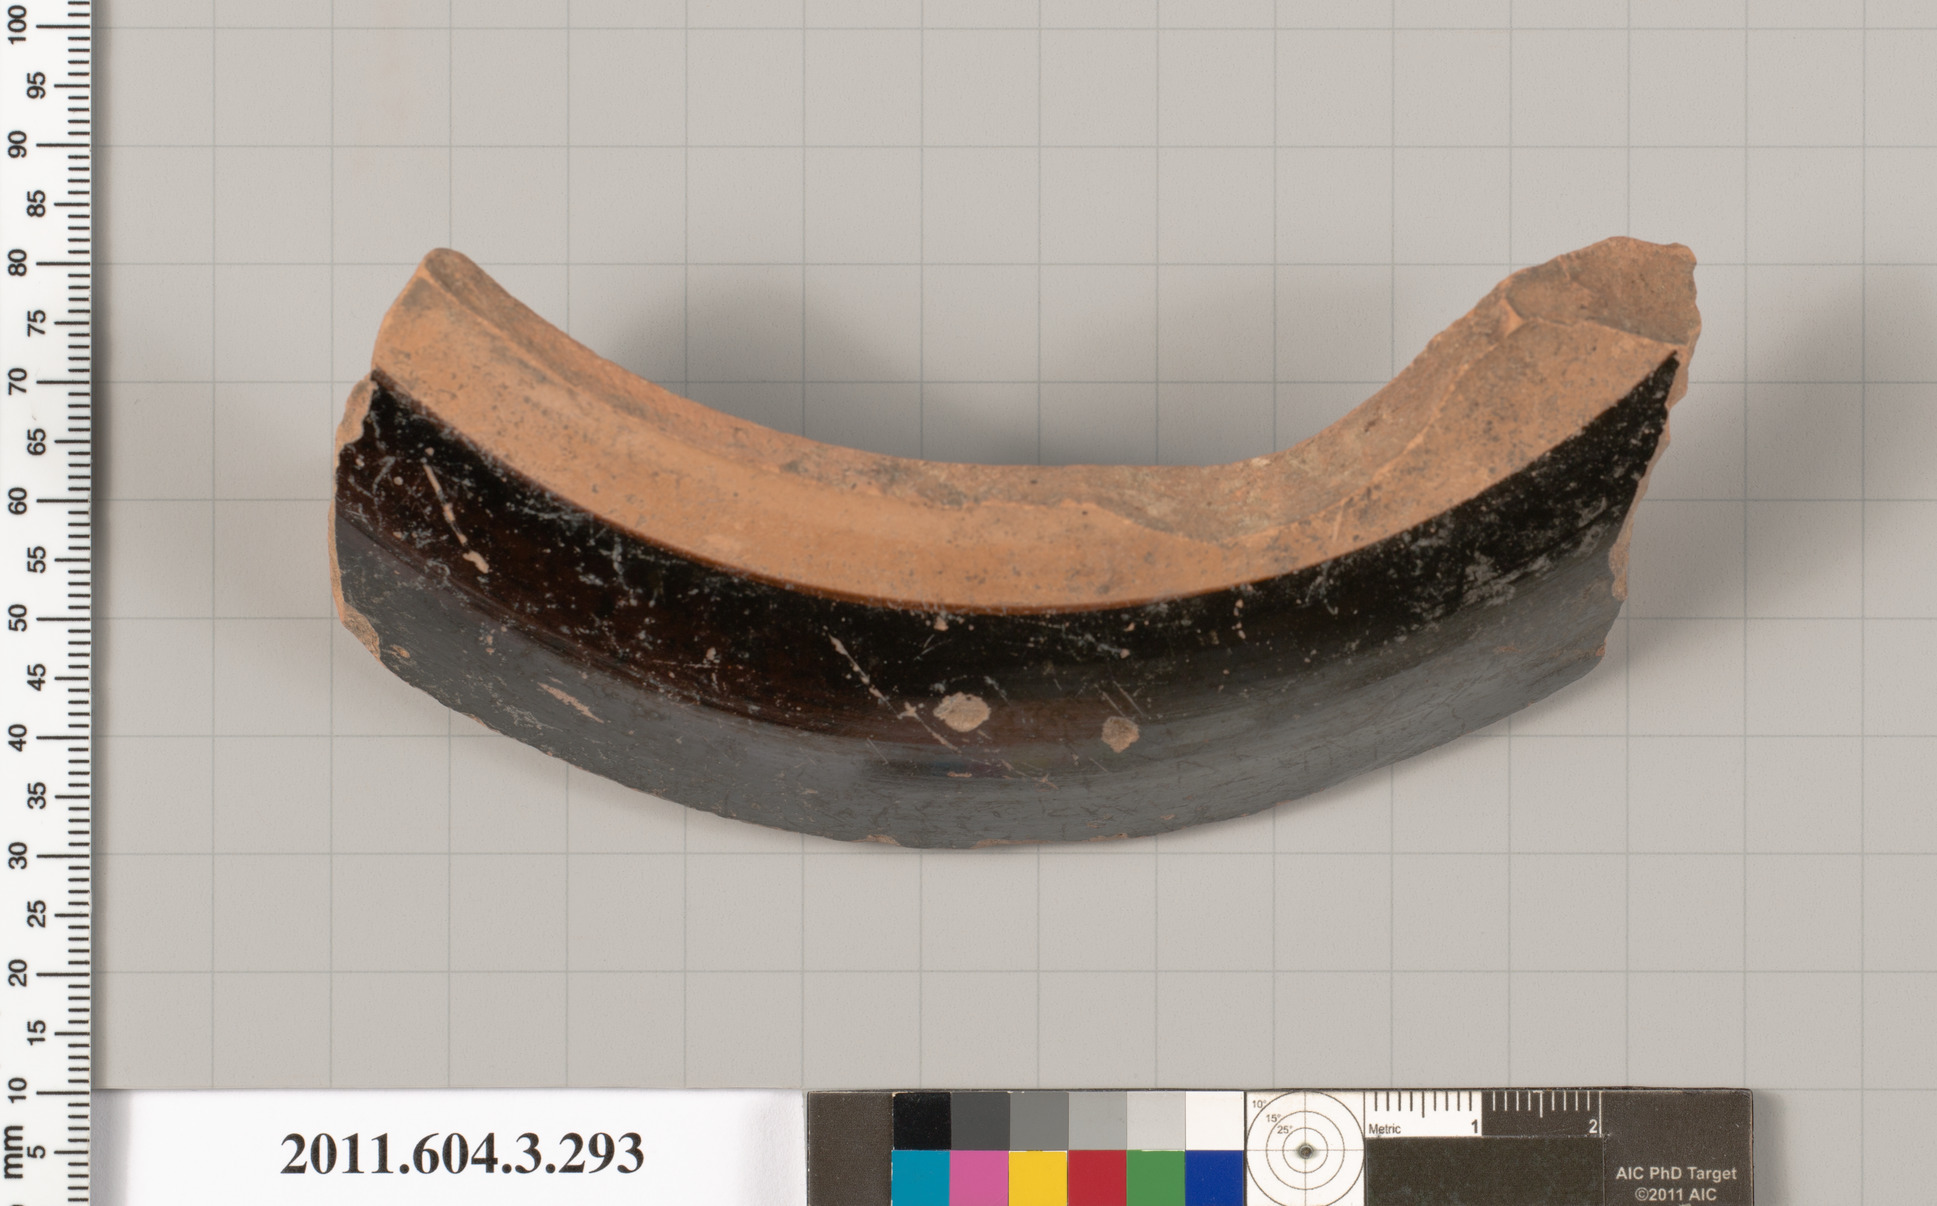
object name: neck amphora fragment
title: Terracotta fragment of a neck-amphora (jar)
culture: greek, attic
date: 600-401 BCE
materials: terracotta